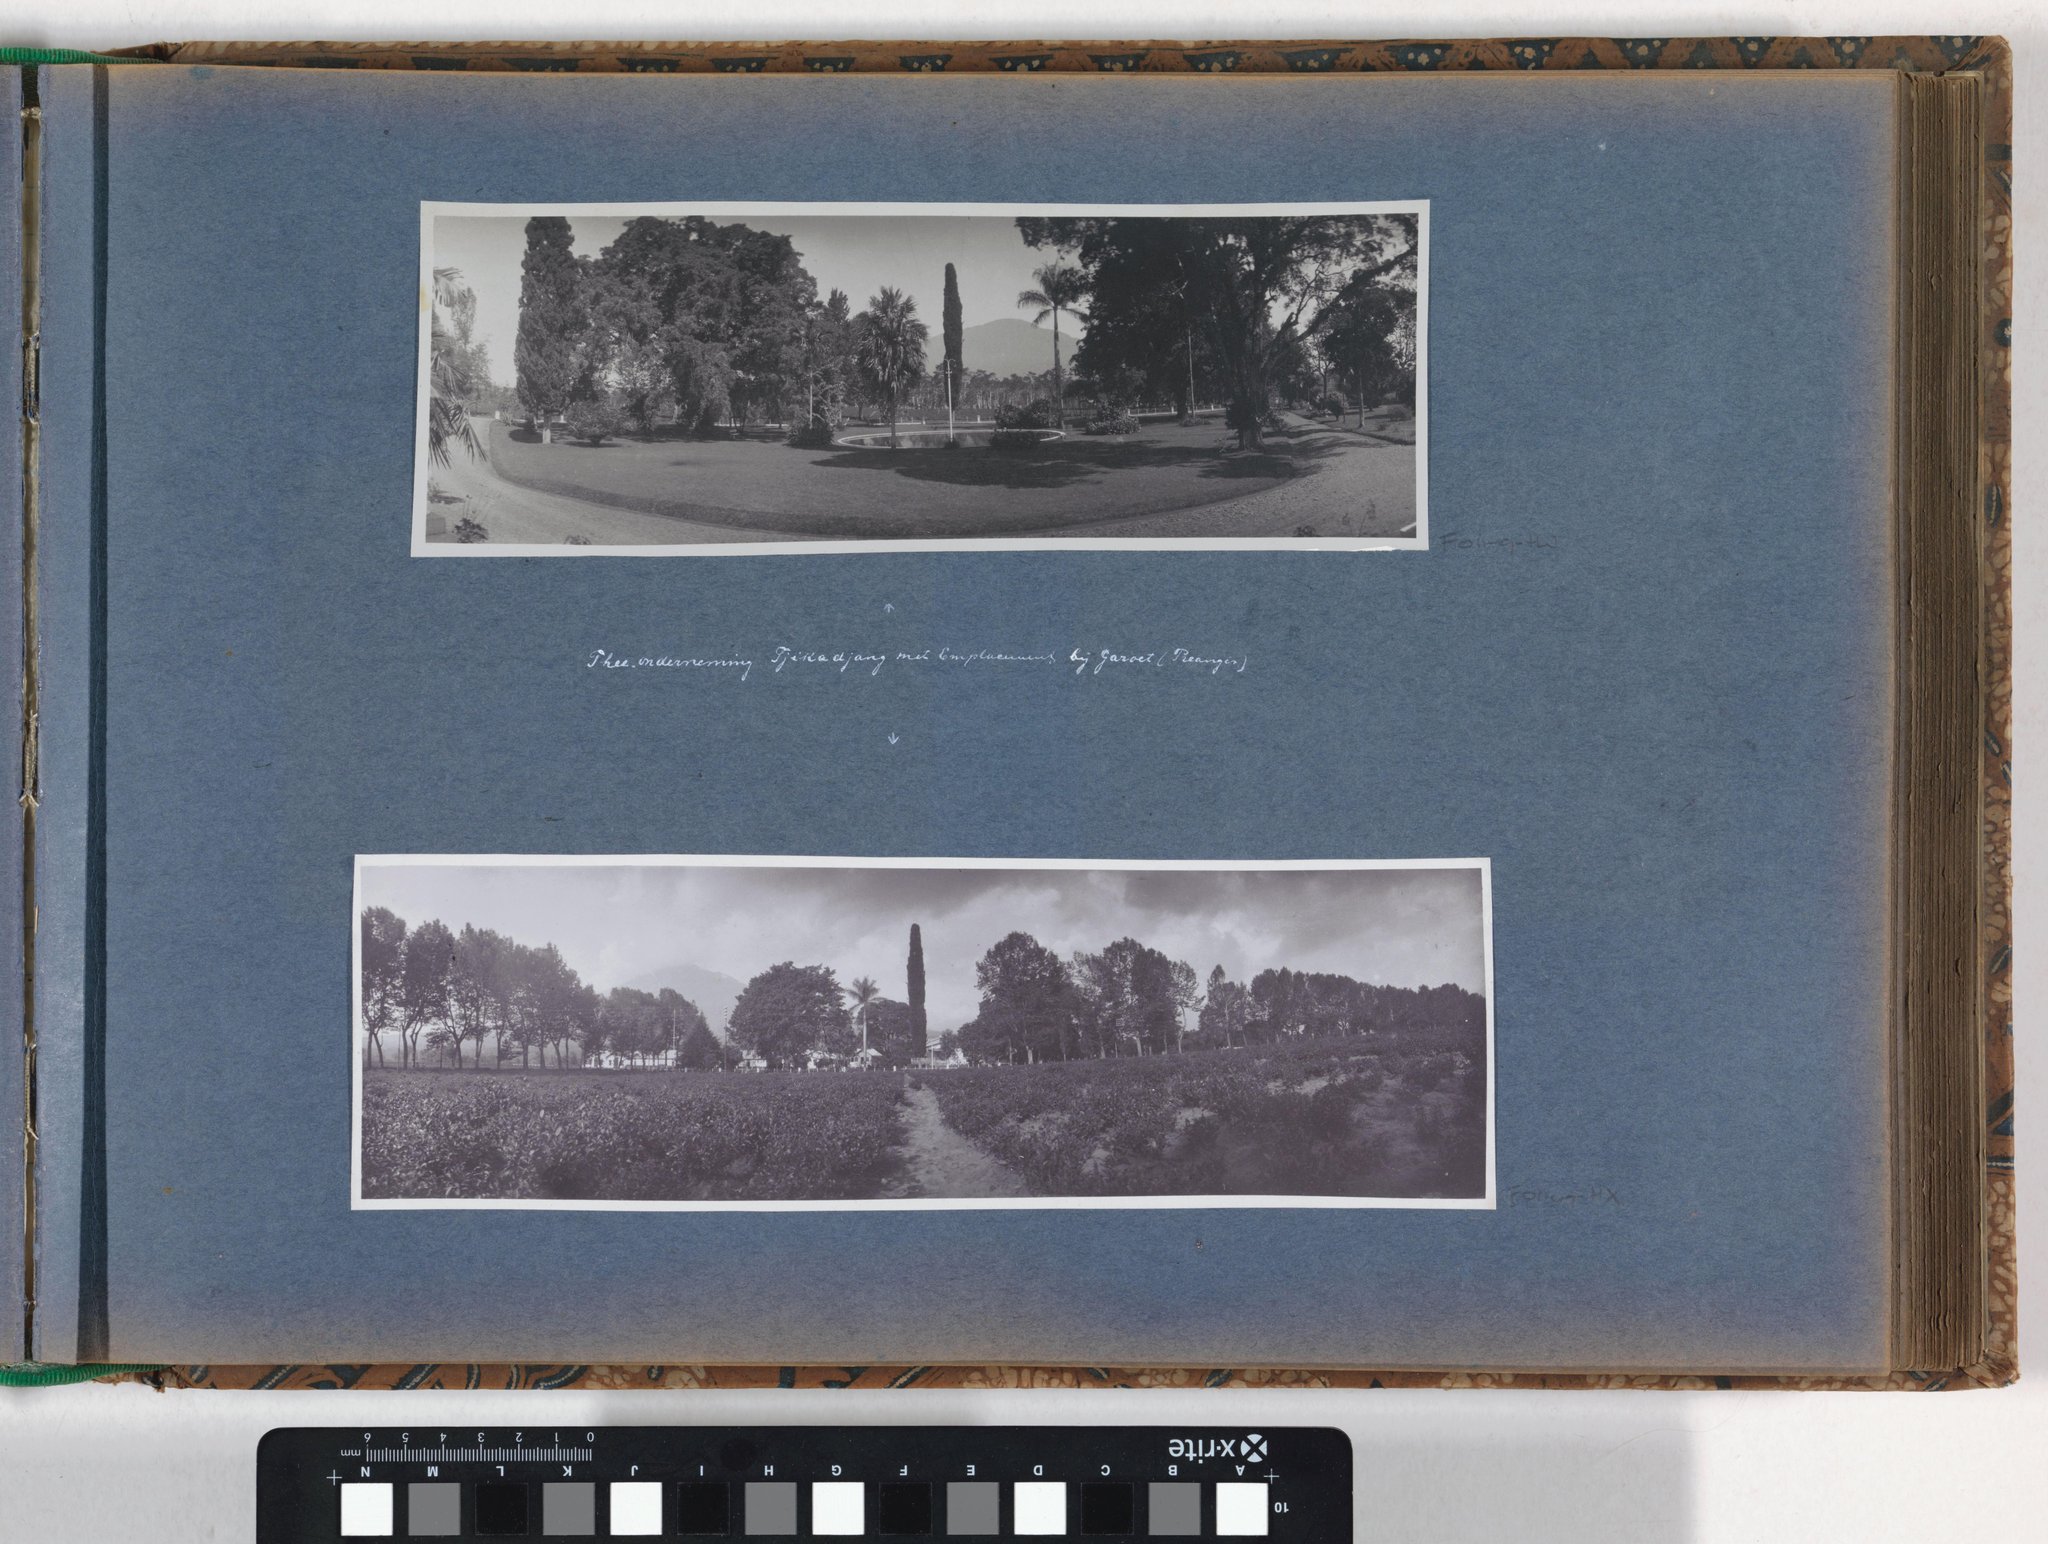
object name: photograph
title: Perk met vijver bij thee-onderneming Tjikadjang bij Garvet in Preanger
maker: Anonymous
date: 1900-1920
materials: paper, photographic support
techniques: gelatin silver print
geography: preanger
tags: plantation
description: Onderdeel van reisalbum met foto's van bedrijvigheid en bezienswaardigheden op Sumatra en Java en van de reis naar en van Nederlands-Indië.